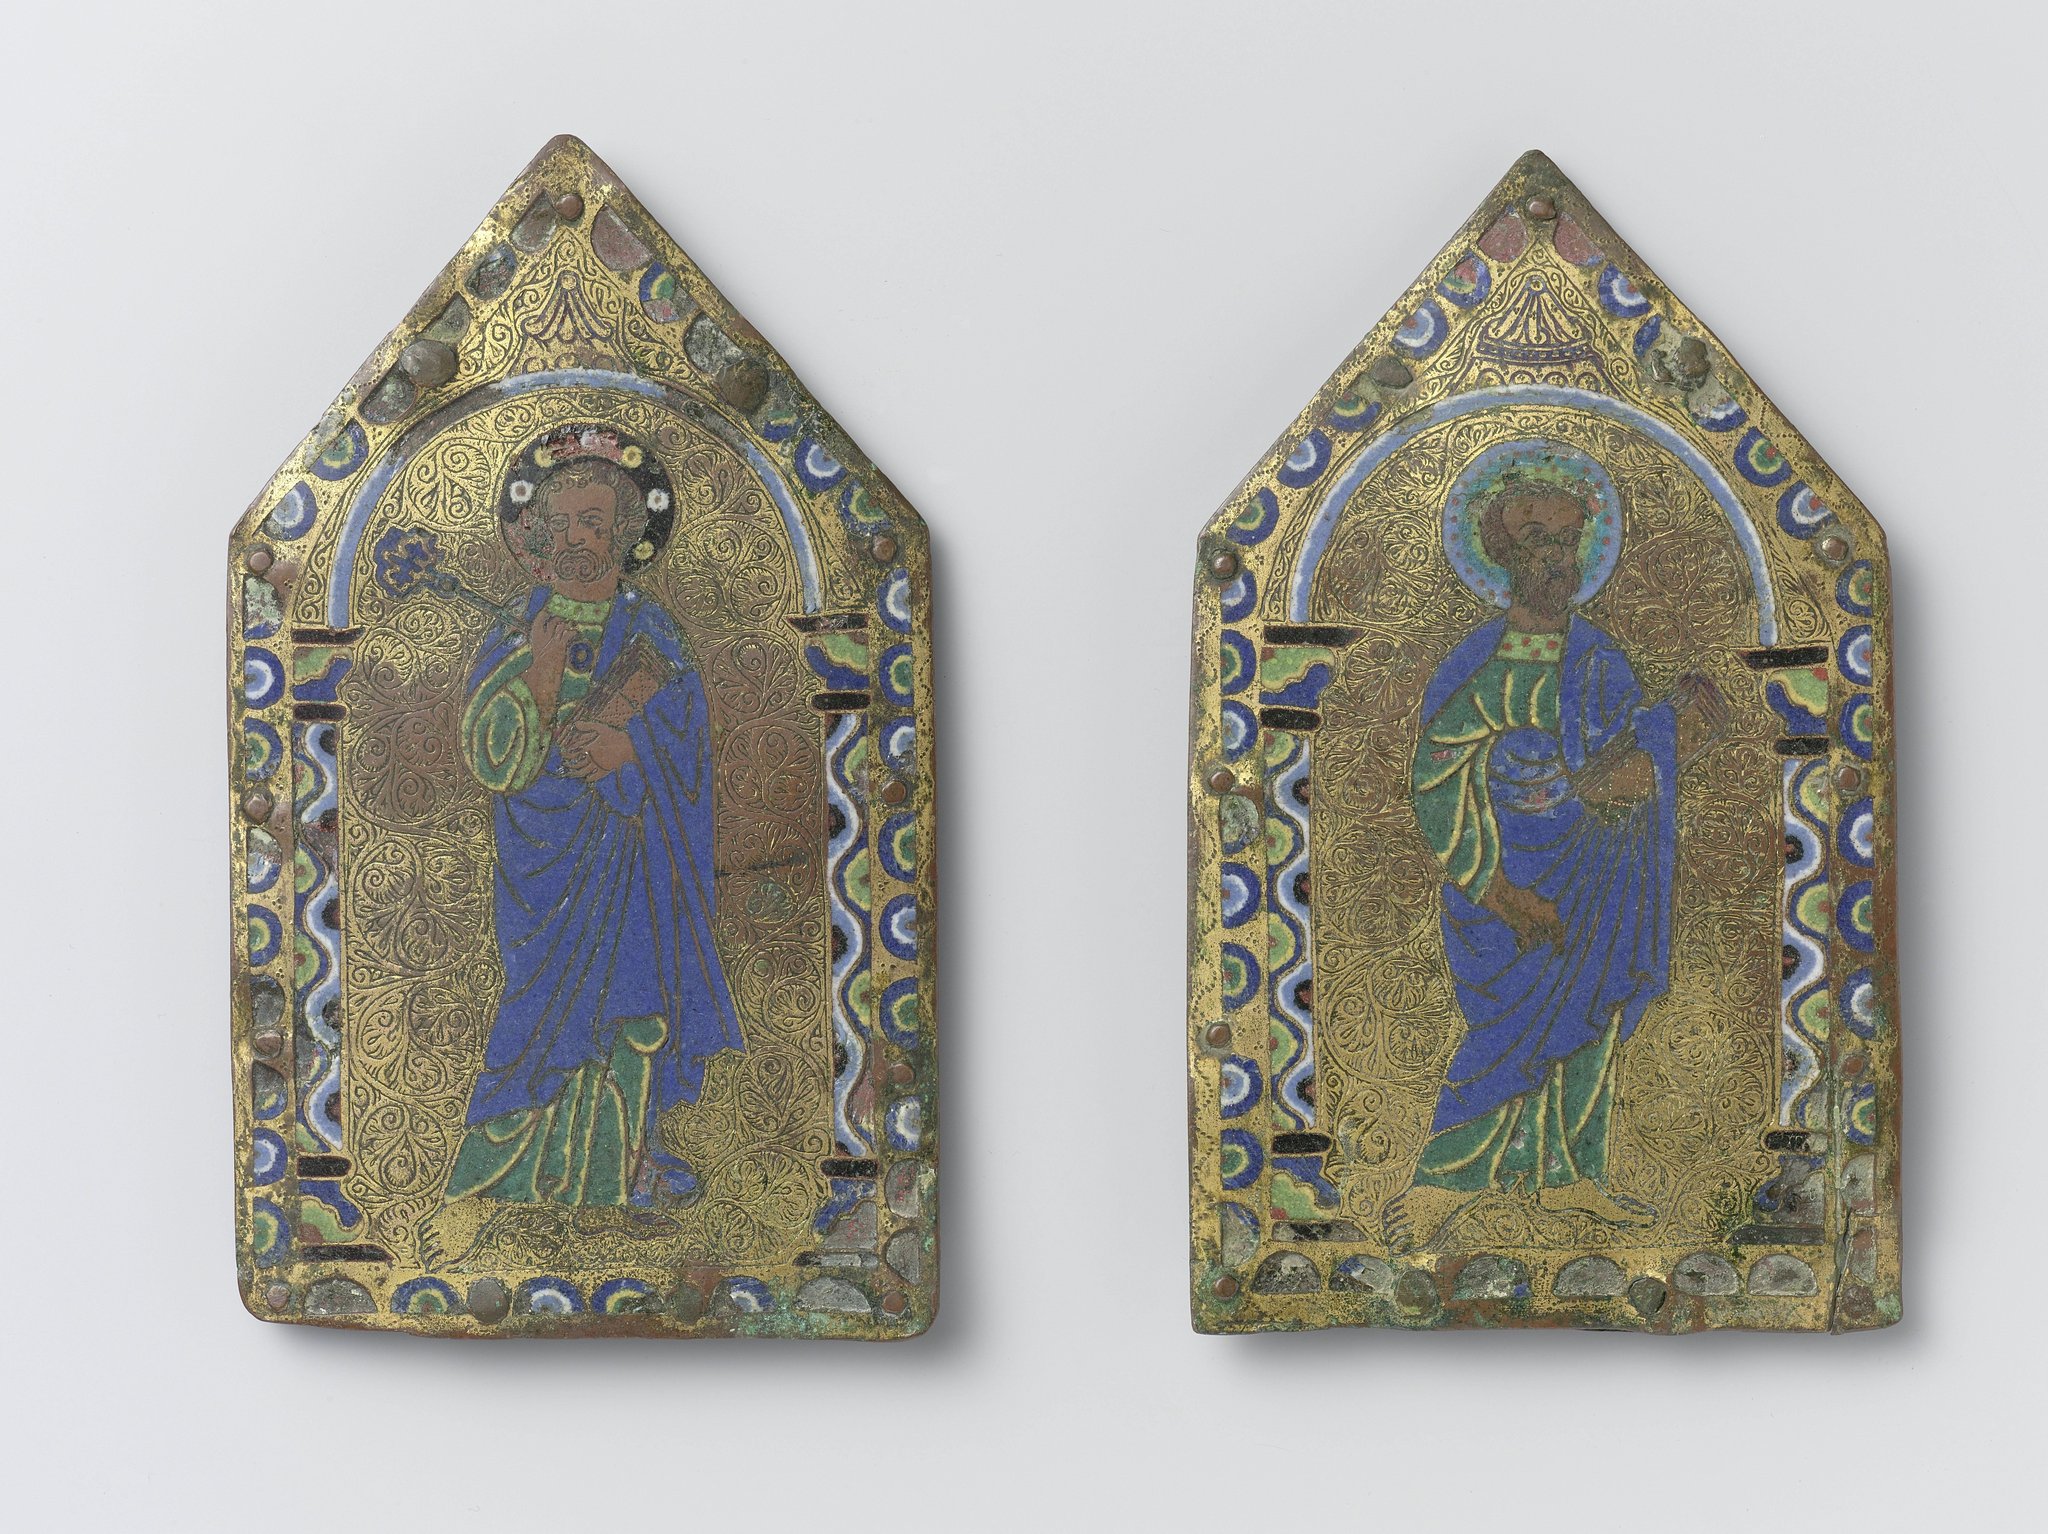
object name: reliquary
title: Zijplaat van een reliquiarium met voorstelling van Petrus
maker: Anonymous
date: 1175-1200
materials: copper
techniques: enamel, gilding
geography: limoges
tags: the apostle peter, first bishop of rome; possible attributes: book, cock, (upturned) cross, (triple) crozier, fish, key, scroll, ship, tiara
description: Two sides of a reliquary châsse (shrine). 13th century.